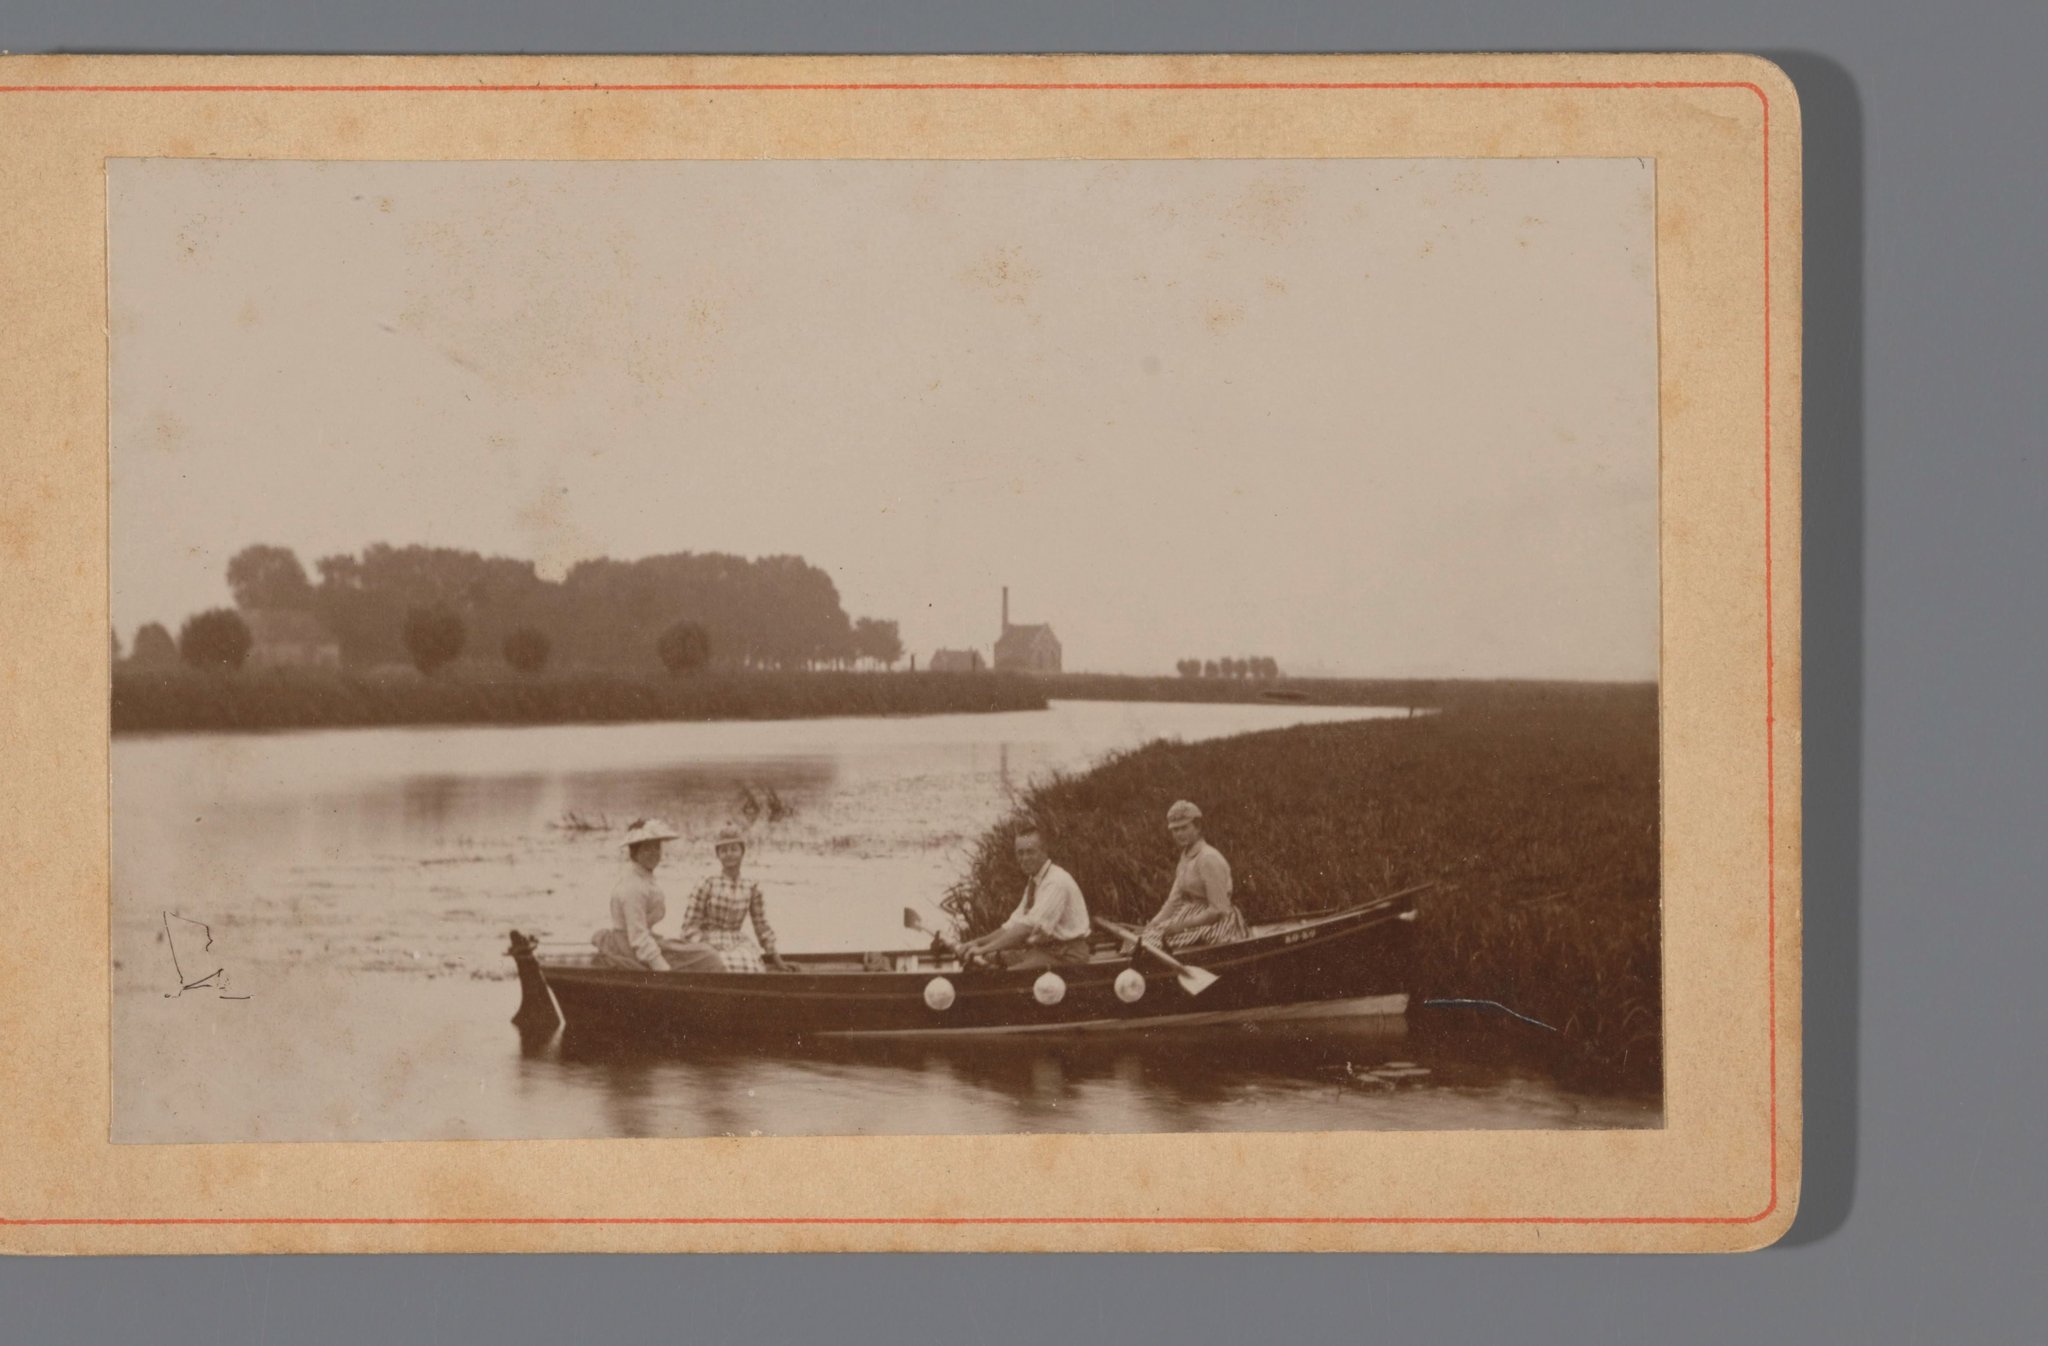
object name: photograph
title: Groepsportret van een gezelschap in een roeiboot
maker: cornelia hendrika jonker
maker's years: 1874-1924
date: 1880-1940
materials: cardboard, photographic support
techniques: collodion silver print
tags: river, rowing-boat, canoe, etc., anonymous historical persons portrayed in a group, in a group-portrait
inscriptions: annotation: ‘t. Marie, oma? Douwe Gorter? t. Jo’